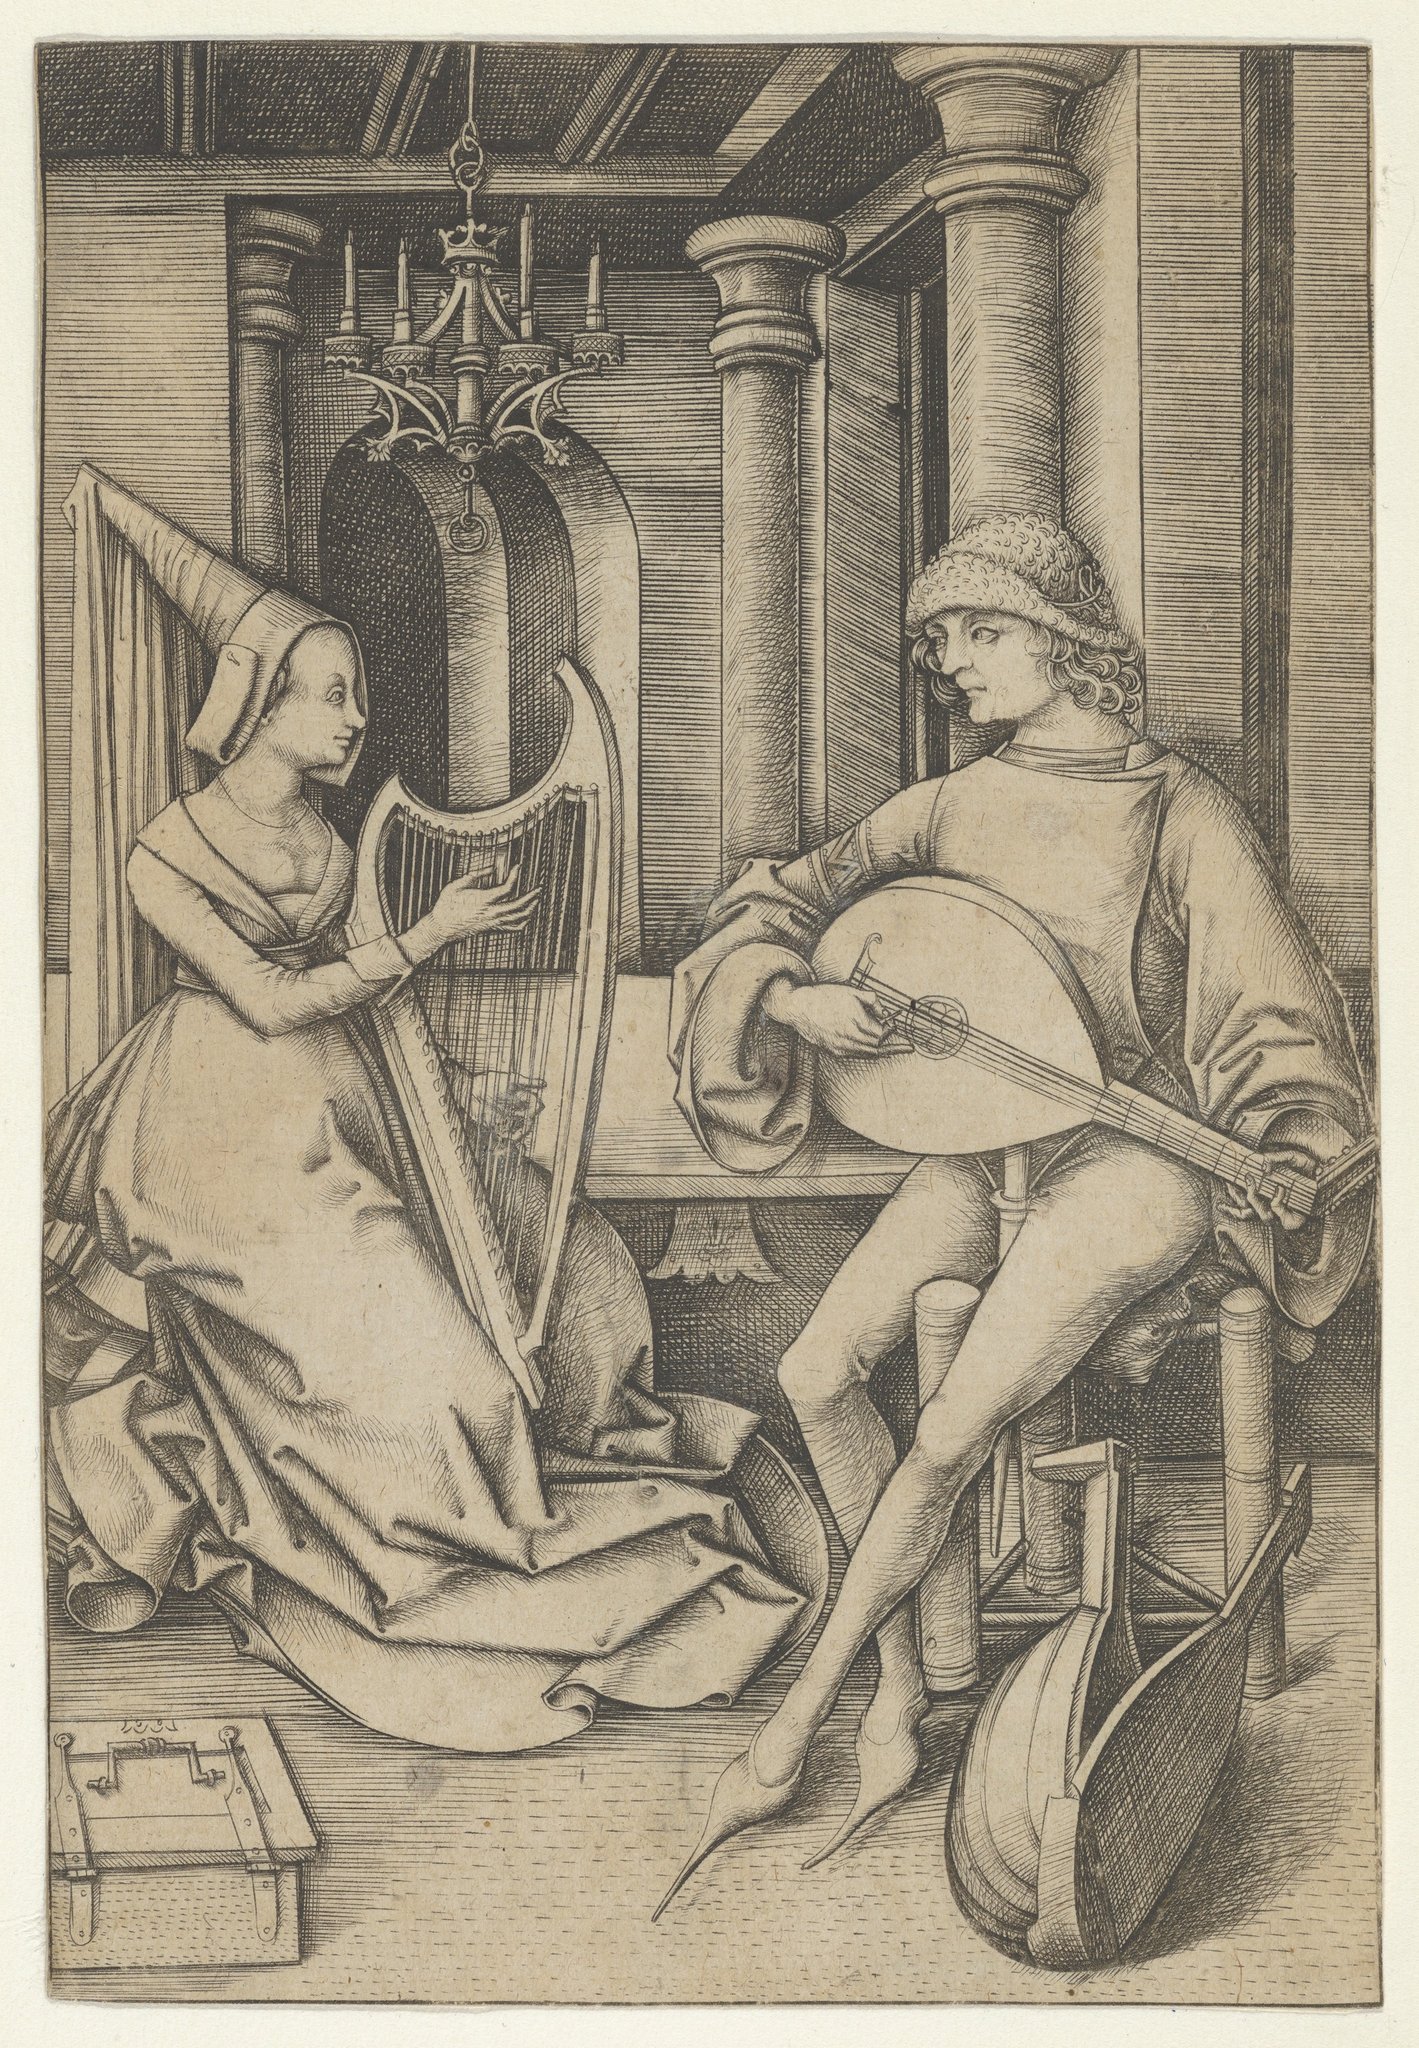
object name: print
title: Lute Player and Harpist, from Scenes of Daily Life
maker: israhel van meckenem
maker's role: artist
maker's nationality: german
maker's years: 1435-1503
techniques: engraving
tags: men,women,harps,lutes,musicians